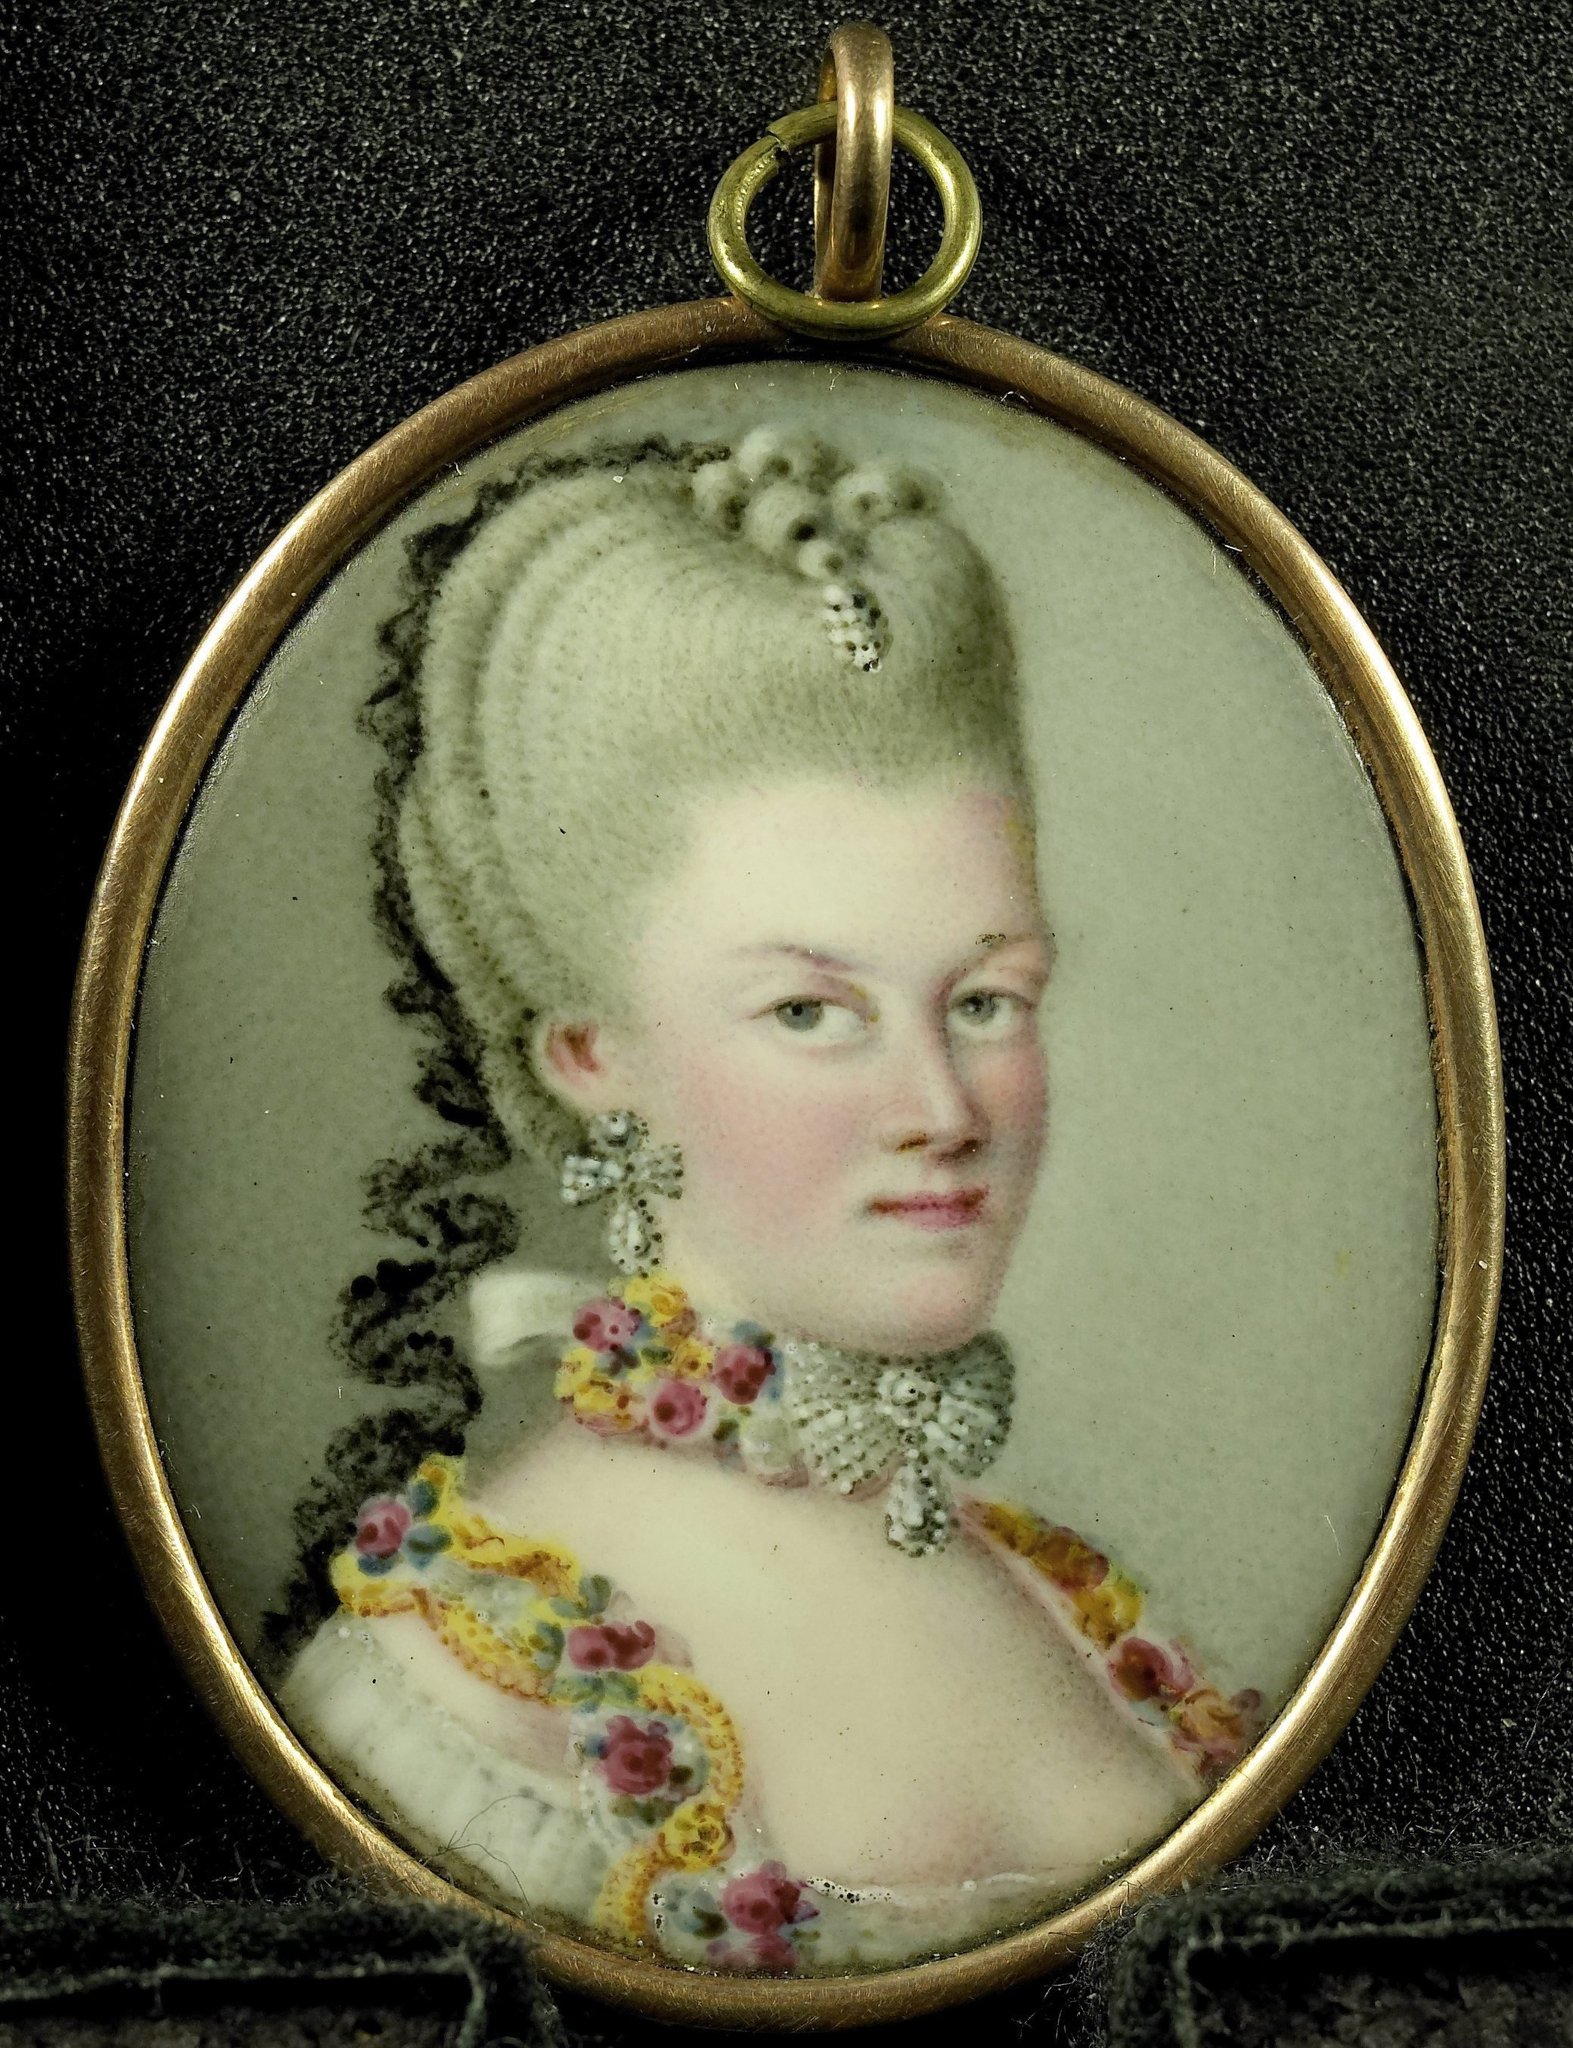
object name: painting, miniature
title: Frederika Sophia Wilhelmina (1751-1820), prinses van Pruisen, echtgenote van prins Willem V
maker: Anonymous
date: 1775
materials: copper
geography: netherlands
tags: painter, wilhelmina of prussia (princess of orange)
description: Portret van Frederika Sophia Wilhelmina (1751-1820), prinses van Pruisen, echtgenote van prins Willem V. Buste, naar rechts, de beschouwer aanziend. Onderdeel van de collectie portretminiaturen.